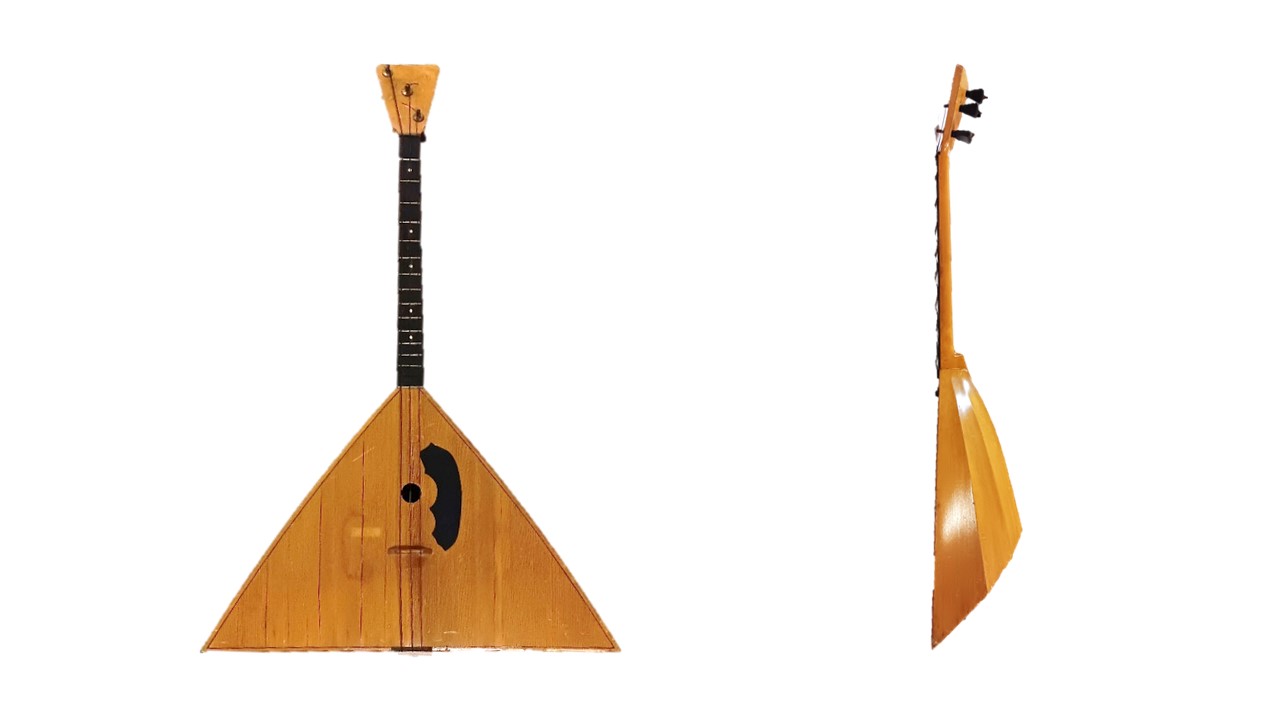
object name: balalaika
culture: russian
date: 1801-1900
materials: wood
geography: russia